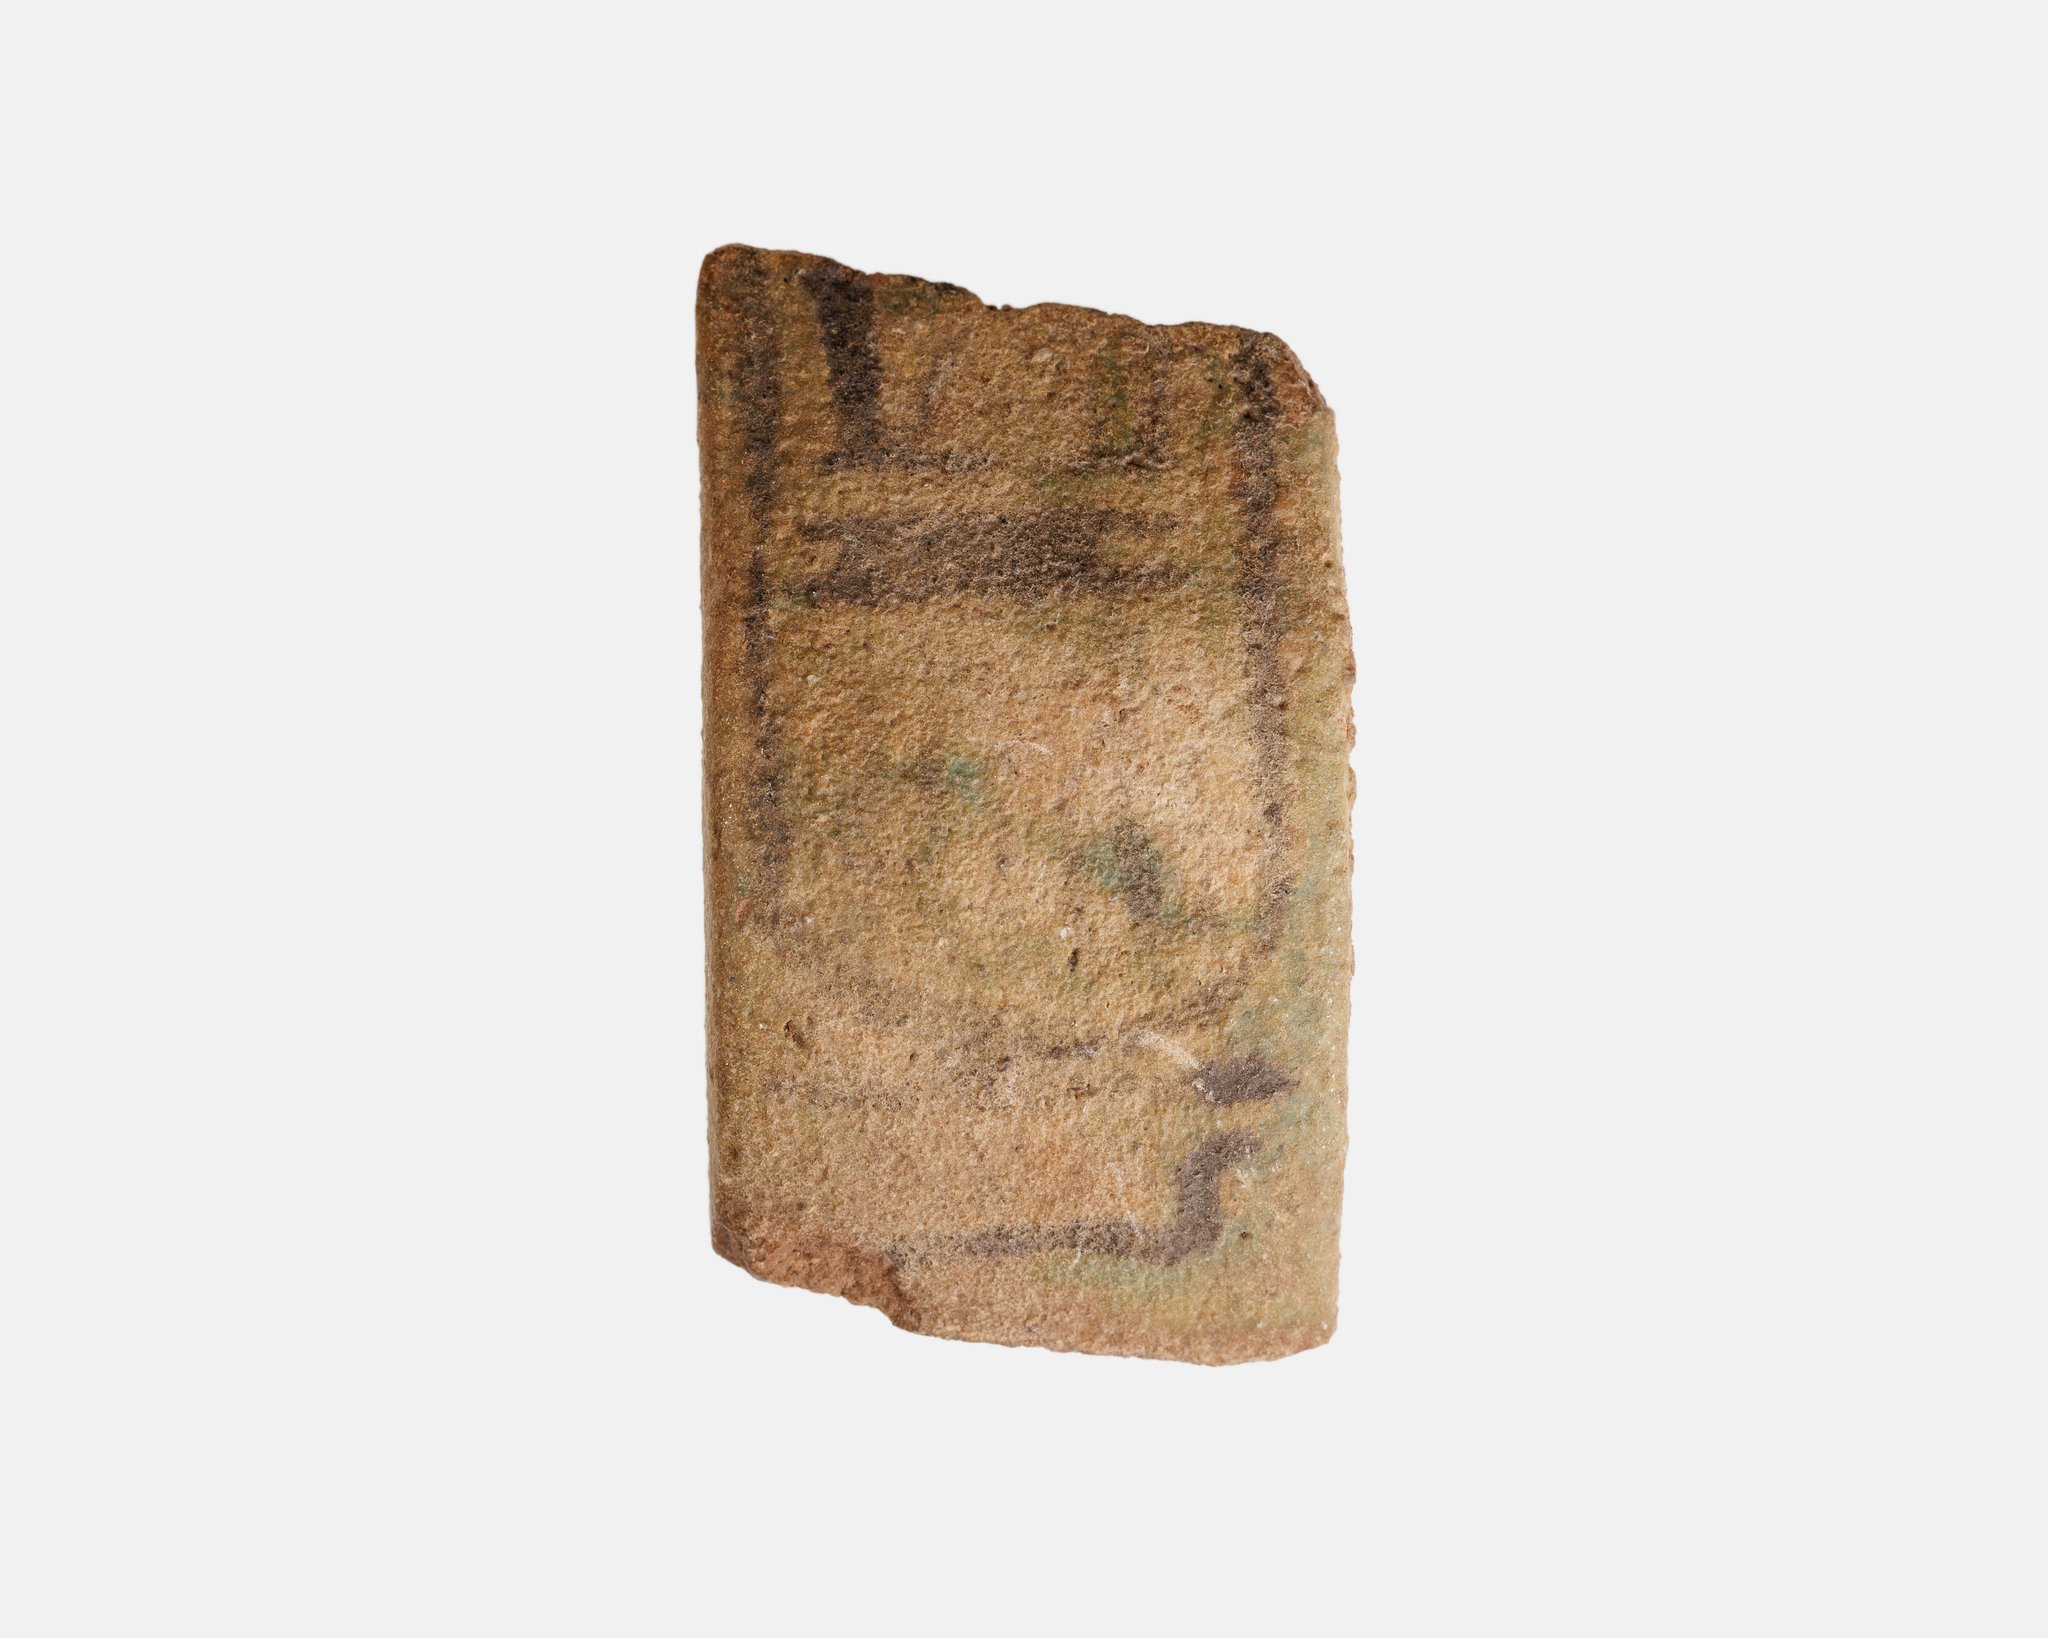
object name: votive bracelet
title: Fragment of a votive bracelet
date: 1295-1070 BCE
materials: faience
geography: egypt